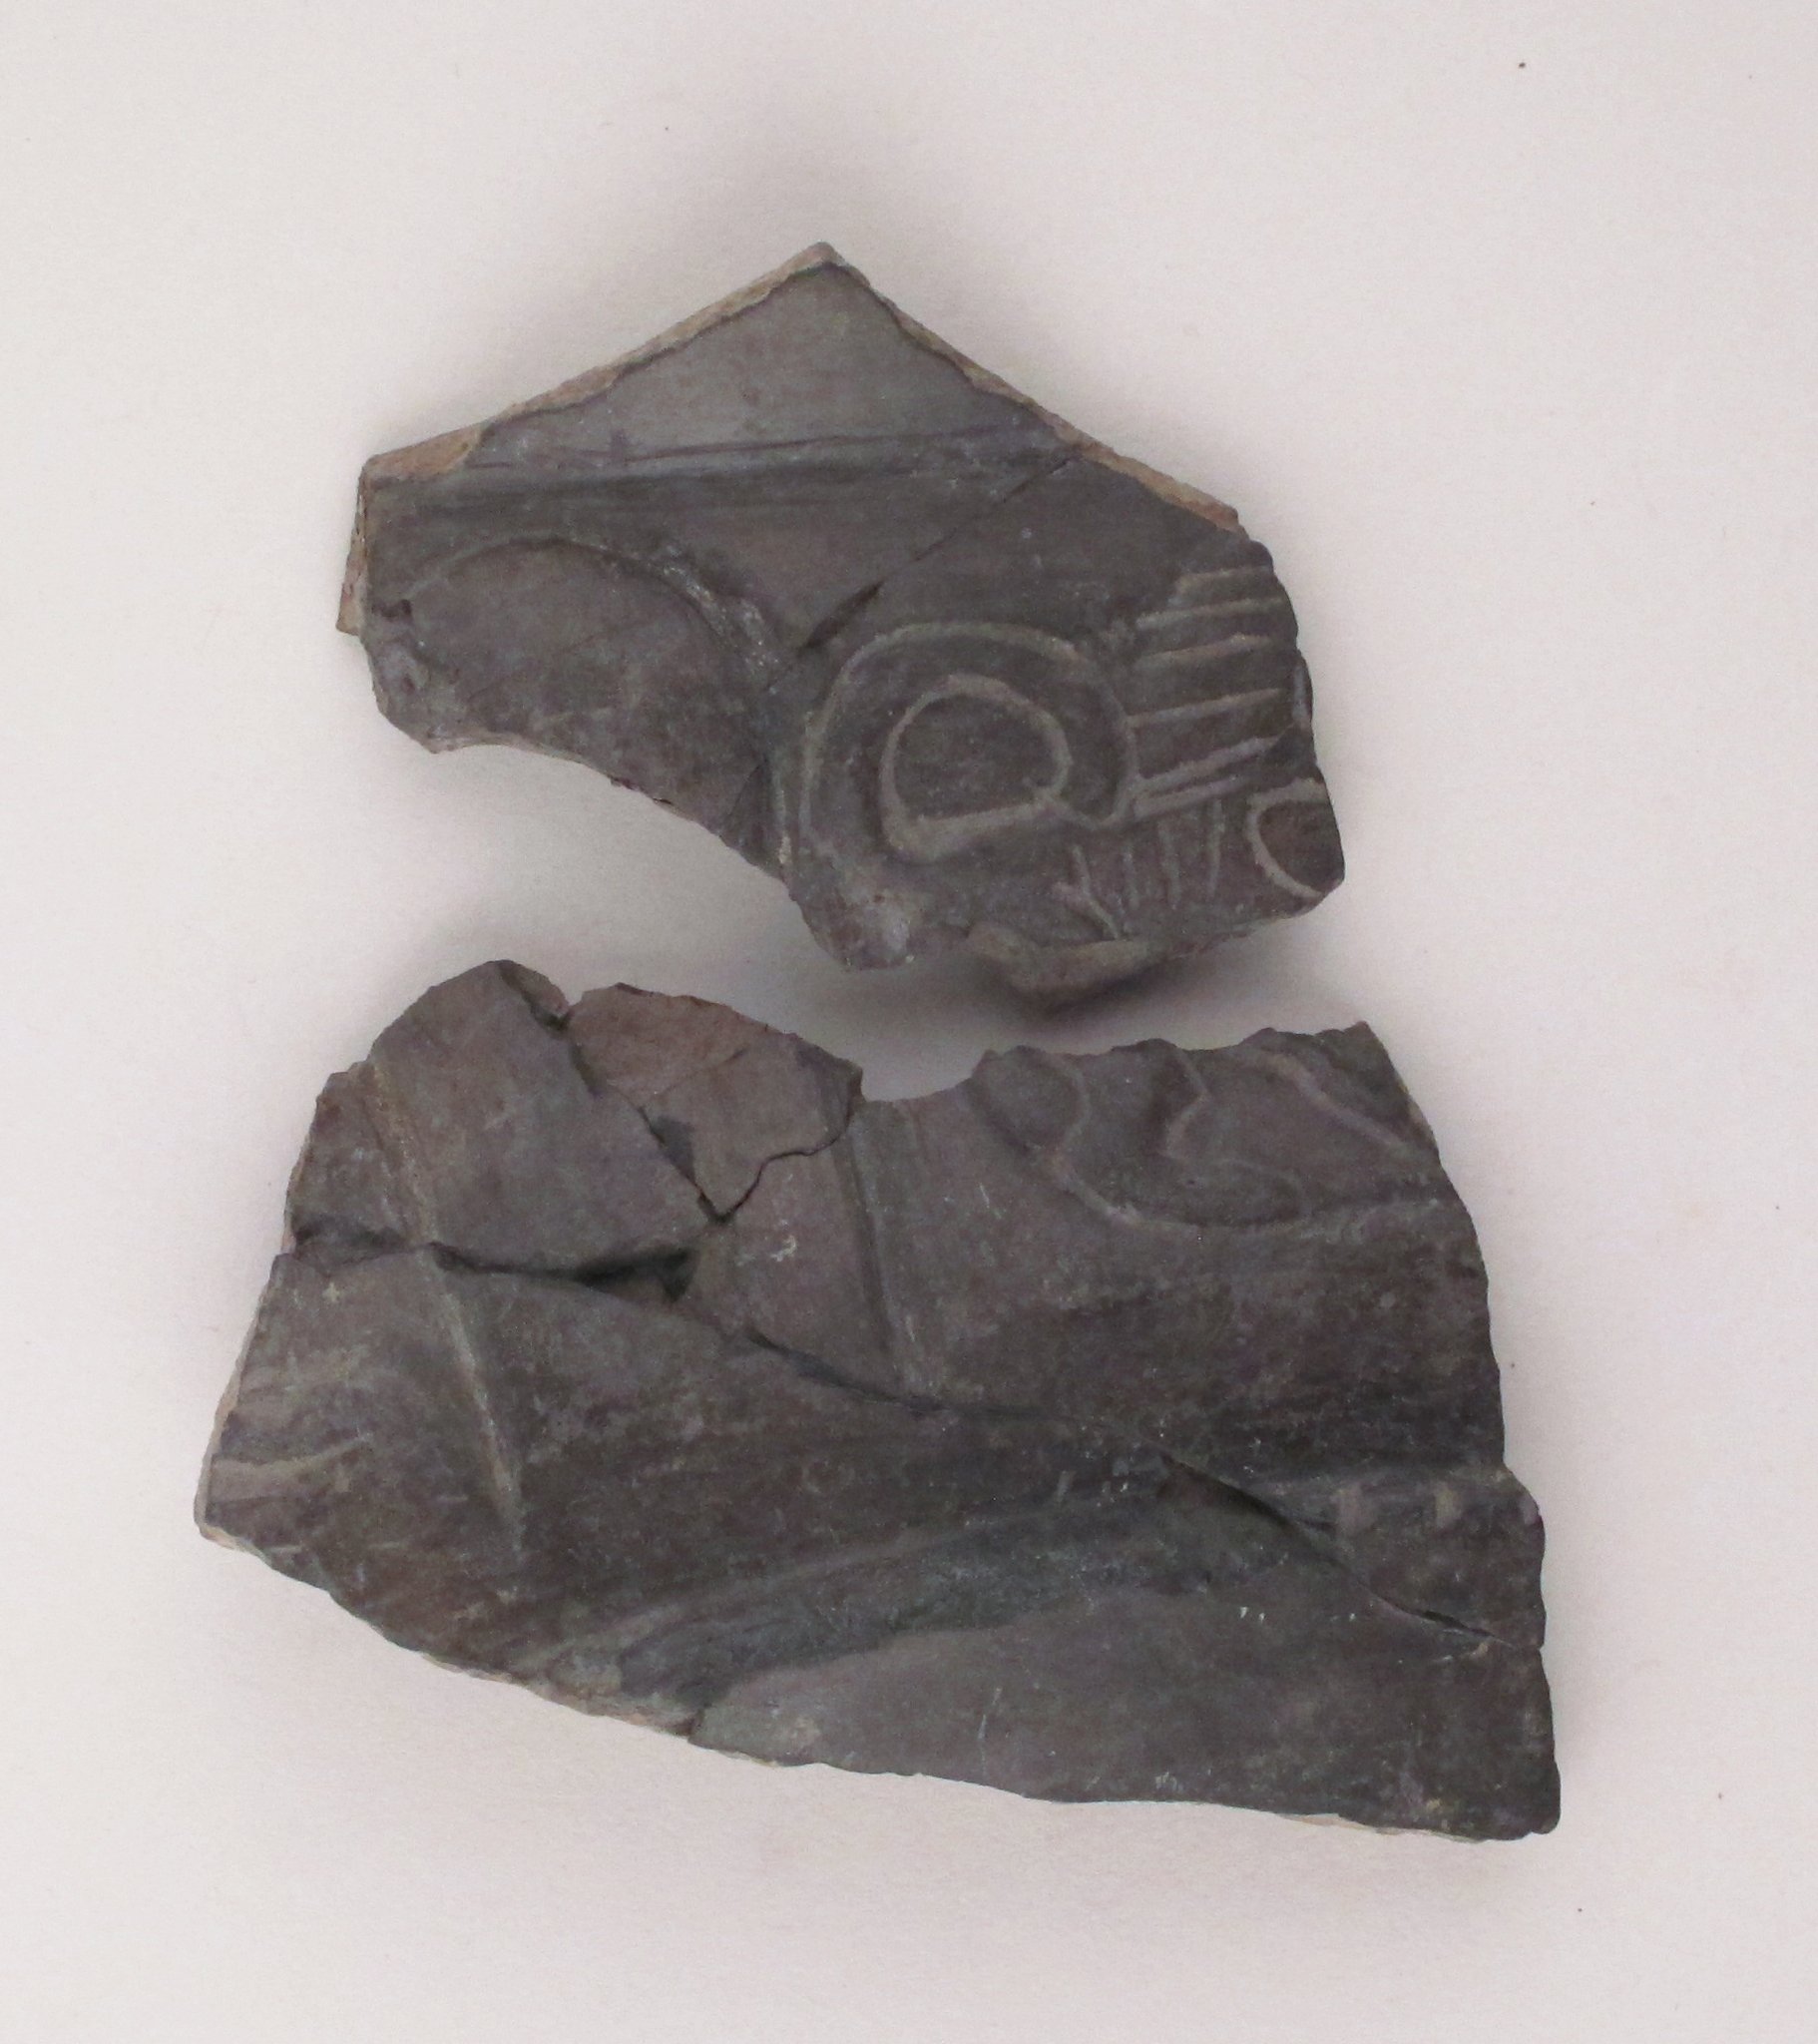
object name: vase fragment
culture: etruscan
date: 580-550 BCE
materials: terracotta